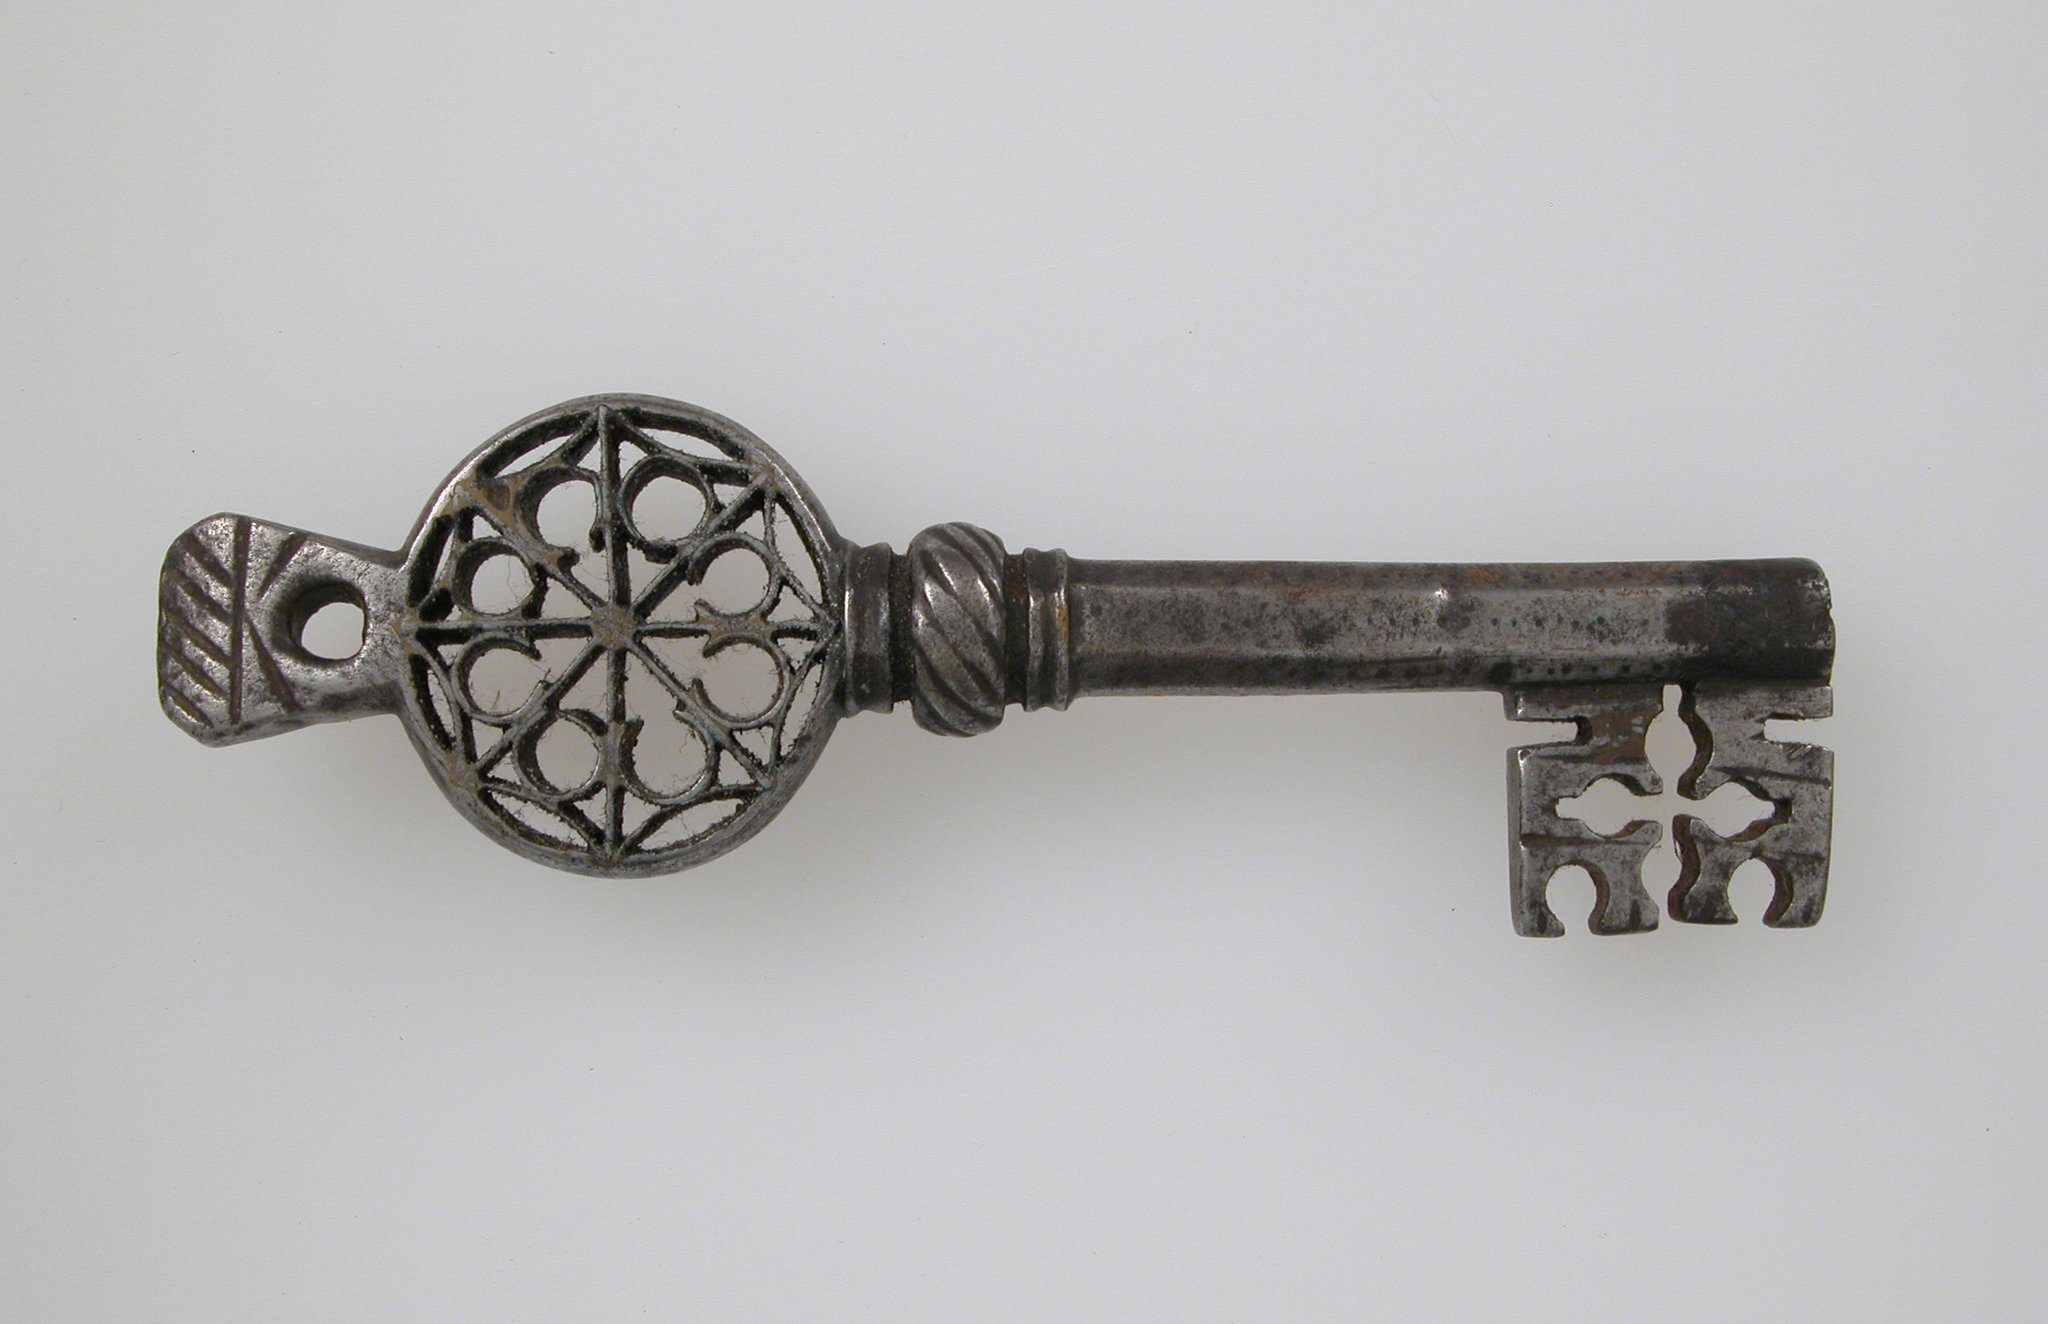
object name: key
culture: german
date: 1401-1500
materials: iron